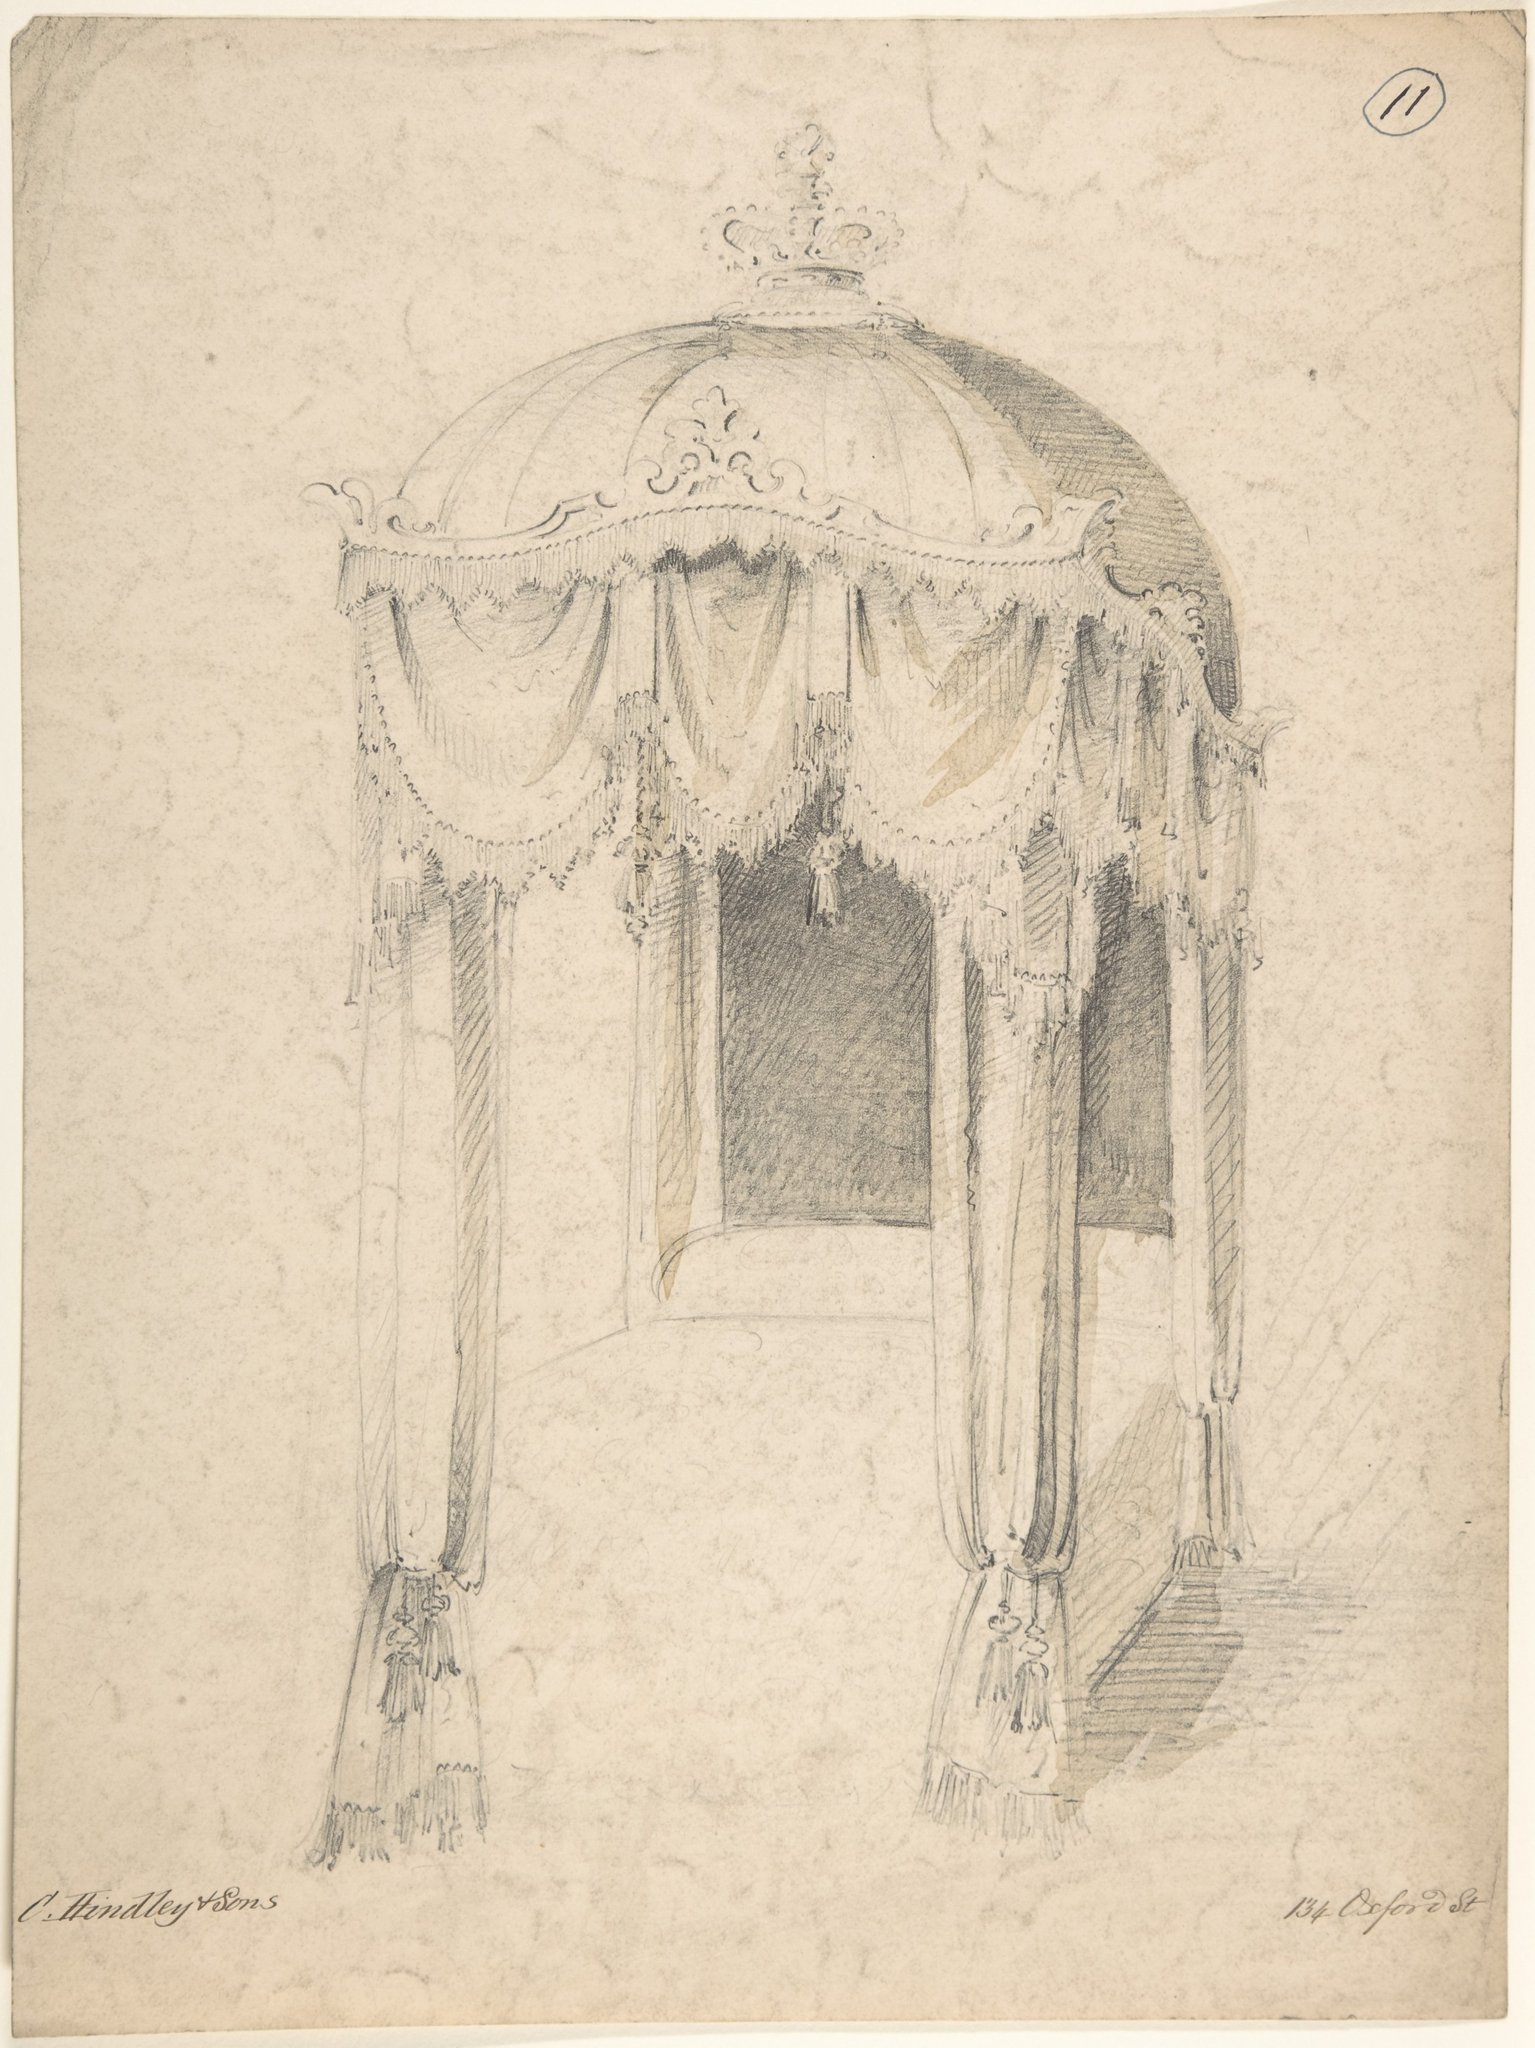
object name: drawing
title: Design for a Bed with Canopy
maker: charles hindley and sons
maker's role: artist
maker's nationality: british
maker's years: 1841-1917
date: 1841-1884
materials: graphite, watercolor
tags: beds